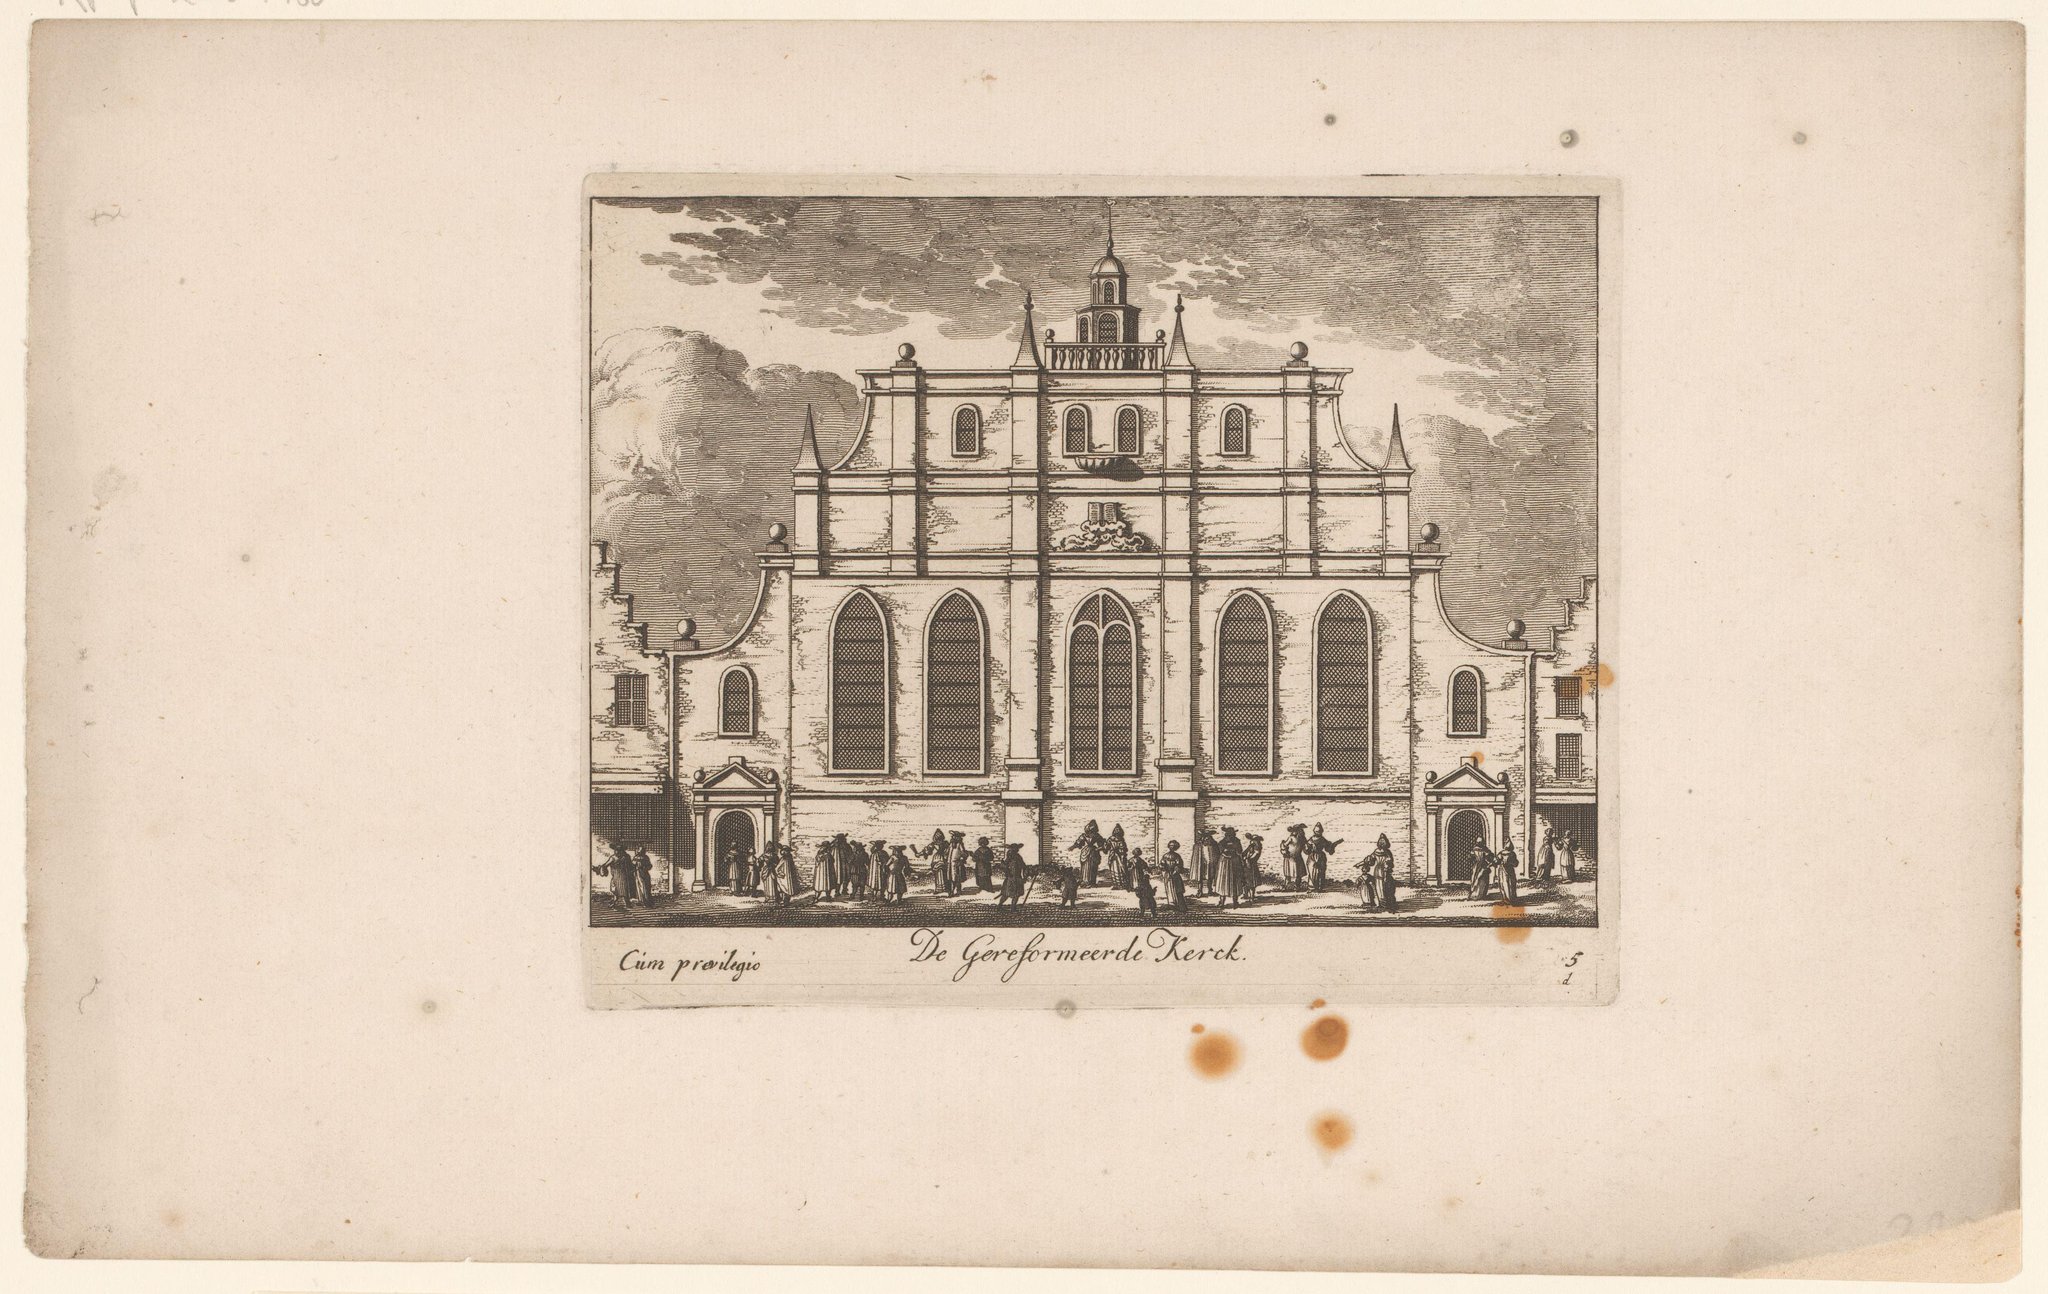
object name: print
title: De Gereformeerde Kerck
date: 1695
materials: paper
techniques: engraving, etching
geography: amsterdam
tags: church (exterior), cleves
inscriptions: collector's mark: Lugt 2228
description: Prent ook gebruikt in: Veues et perspectives de la ville de Cleves, et de sa cour. Amsterdam: Gerard Valck, 1695.